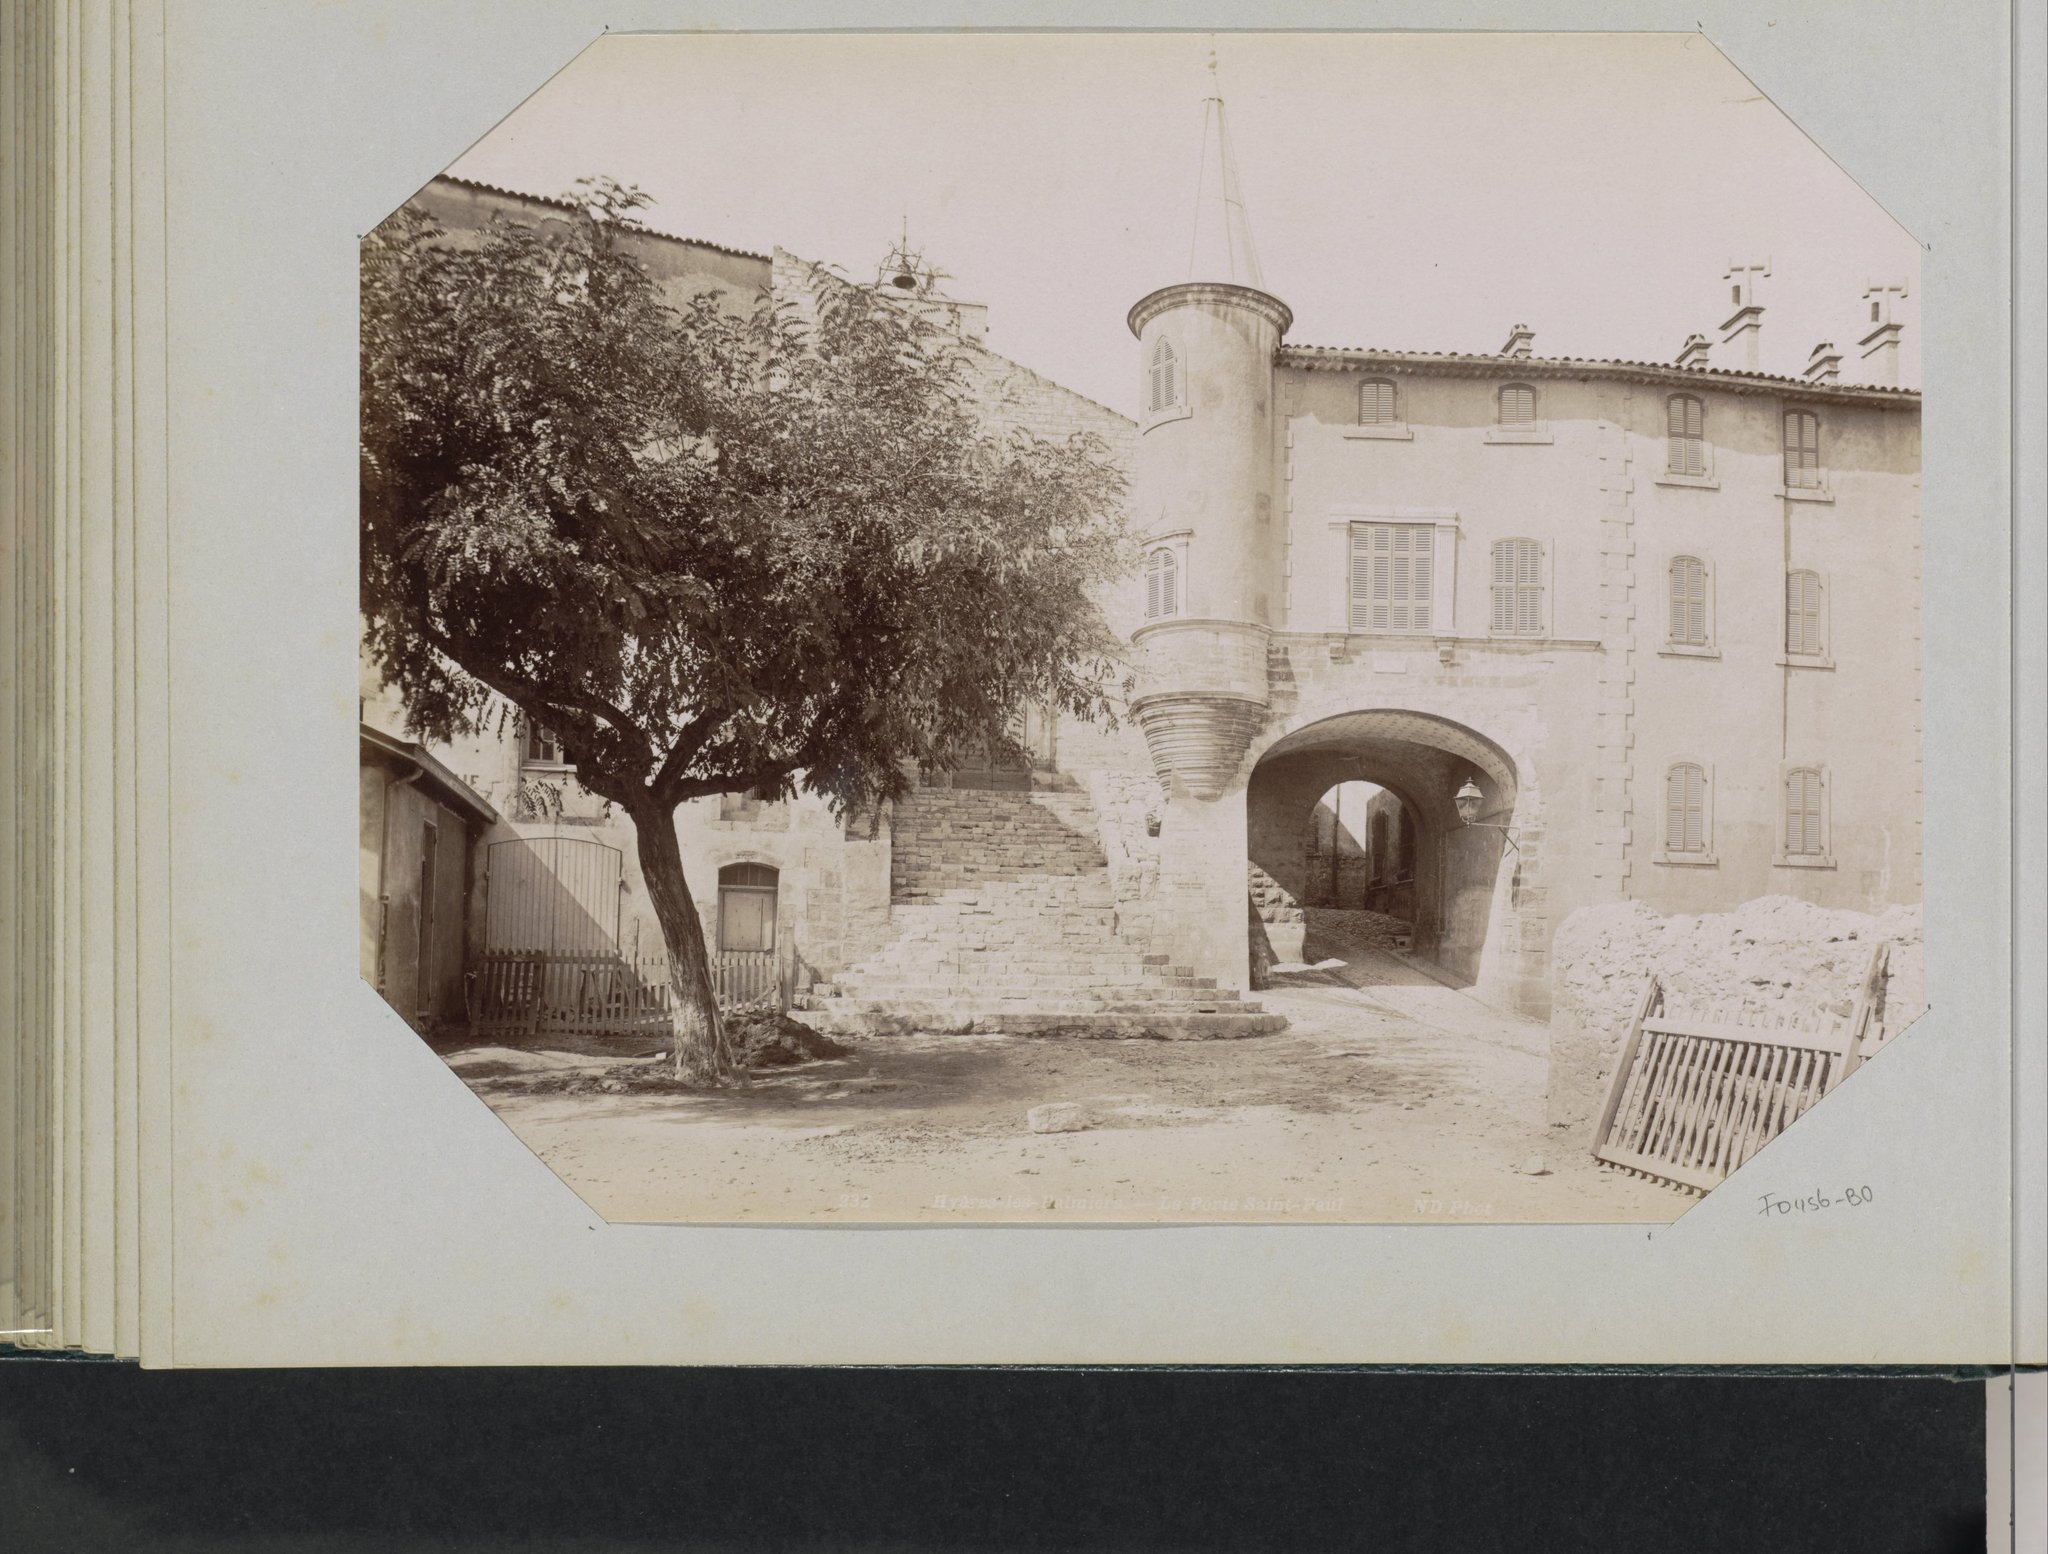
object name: album leaf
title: Gezicht op de Porte Saint-Paul te Hyères-les-Palmiers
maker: étienne neurdein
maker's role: publisher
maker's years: 1832-1918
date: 1896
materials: photographic support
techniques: albumen print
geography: hyères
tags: city-gate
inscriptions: inscription: ‘232 Hyères-les-Palmiers - La Porte Saint-Paul ND. Phot.’